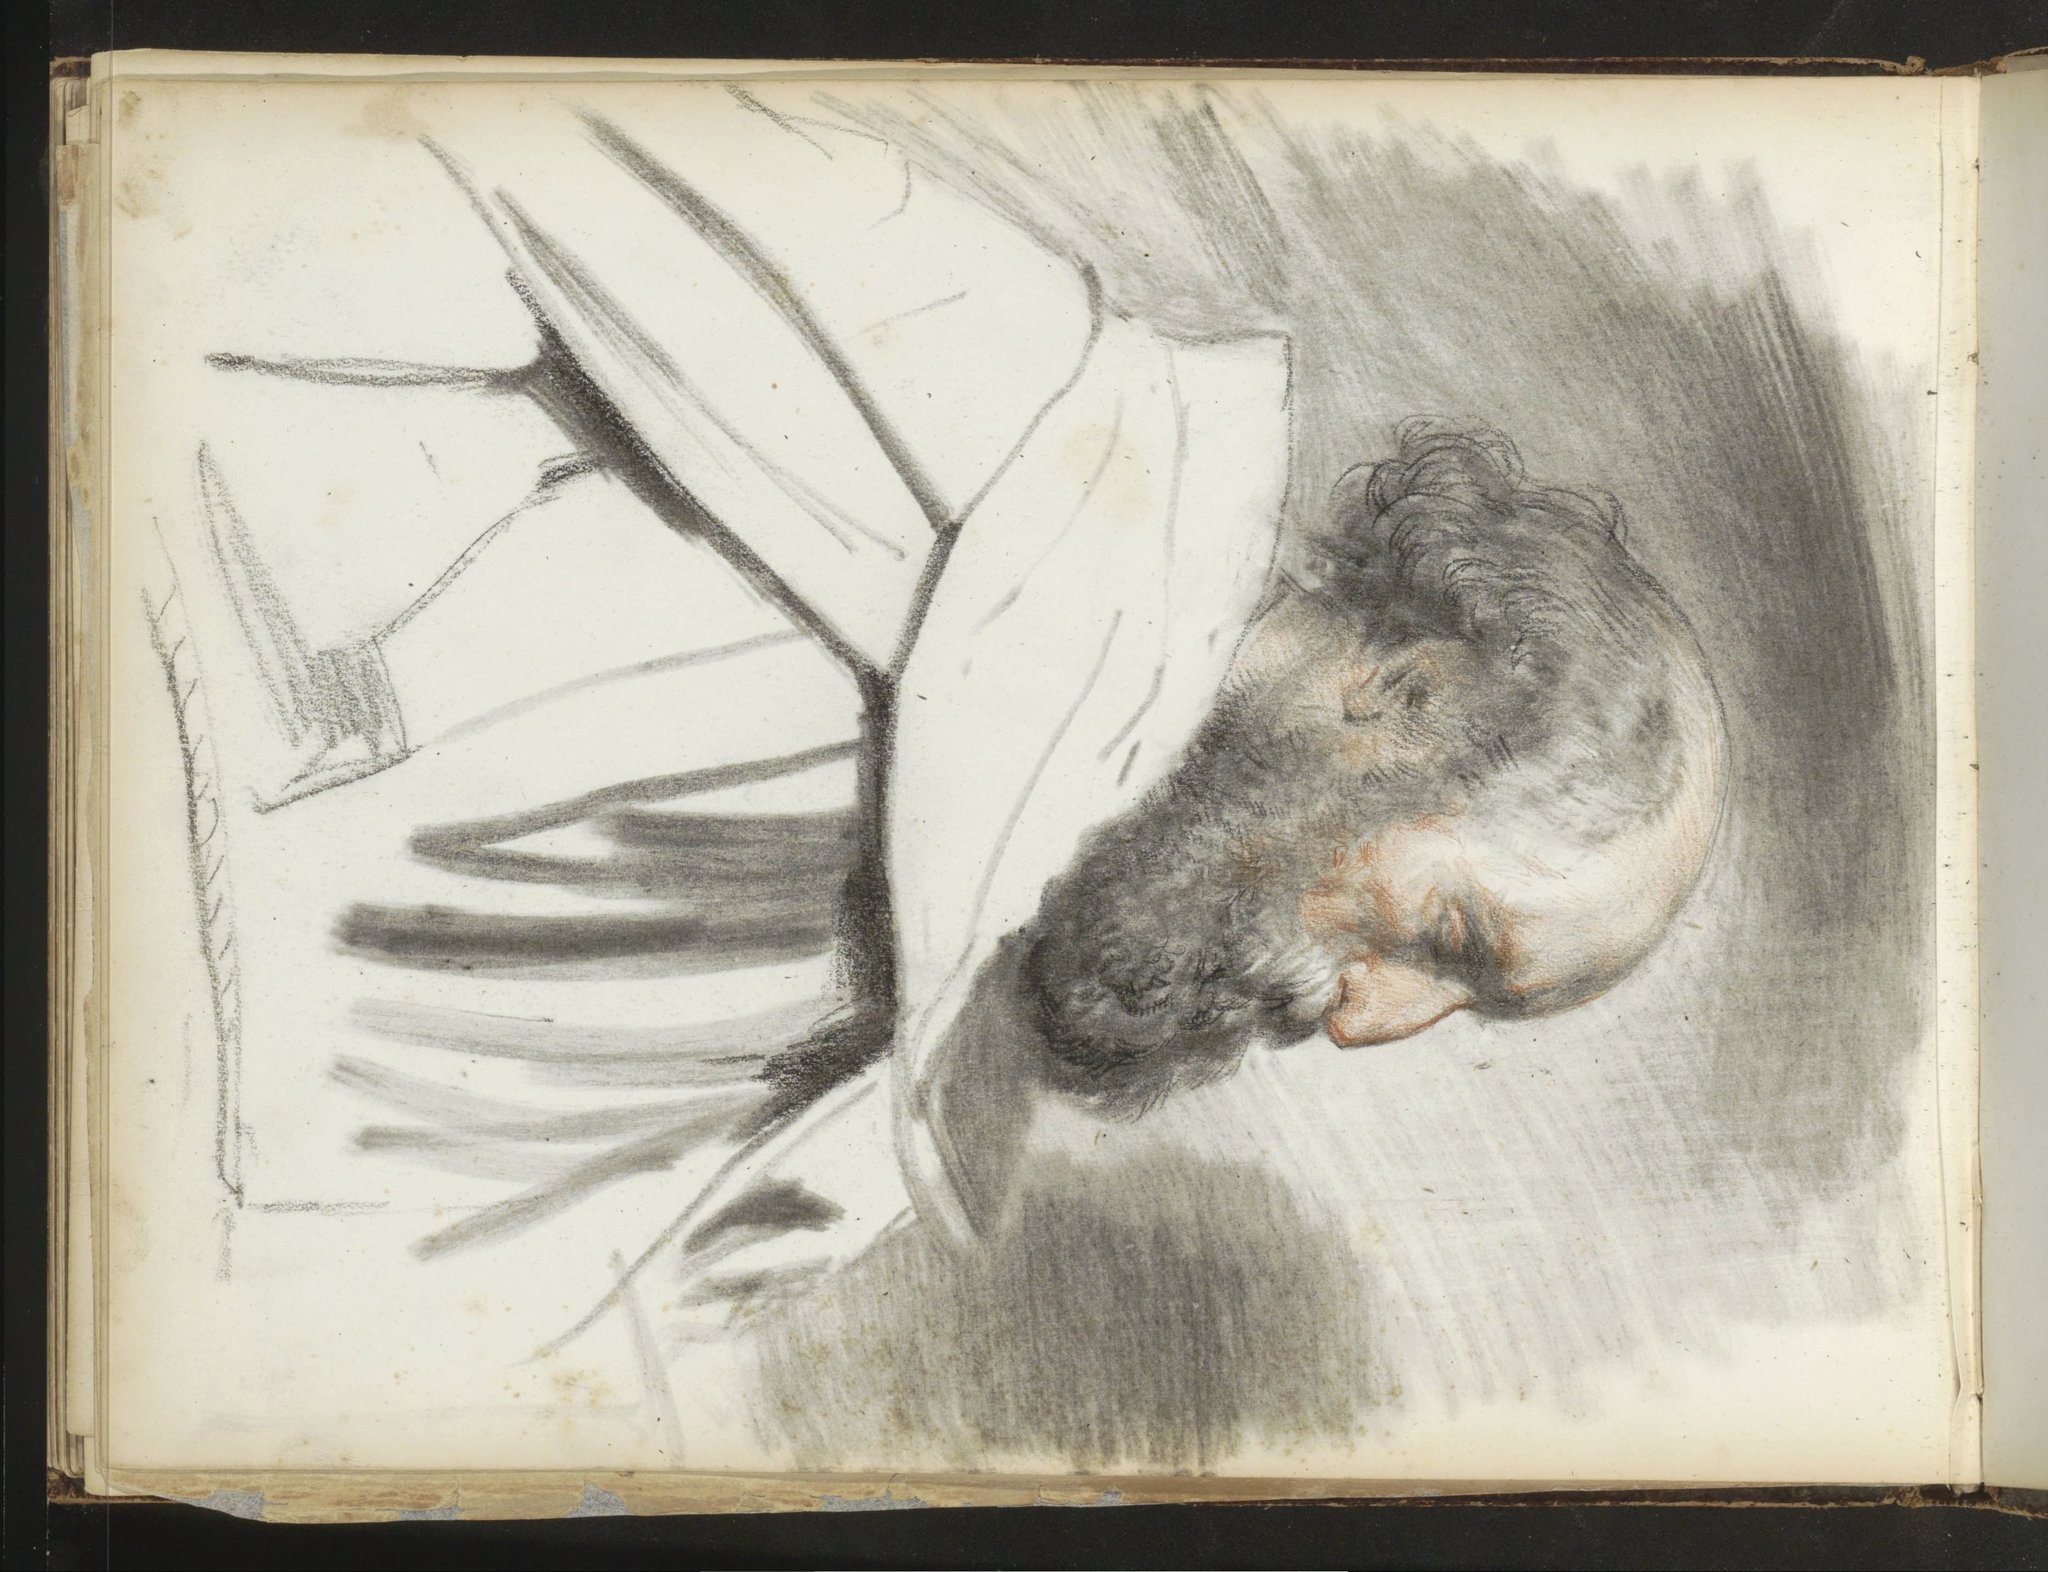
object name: sketchbook leaf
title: Monnik met een baard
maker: reinier craeyvanger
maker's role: draughtsman, print maker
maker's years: 1812-1880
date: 1822-1880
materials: chalk, charcoal, paper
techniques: stumping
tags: monk(s), friar(s)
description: Blad 38 verso uit een schetsboek met 45 bladen.